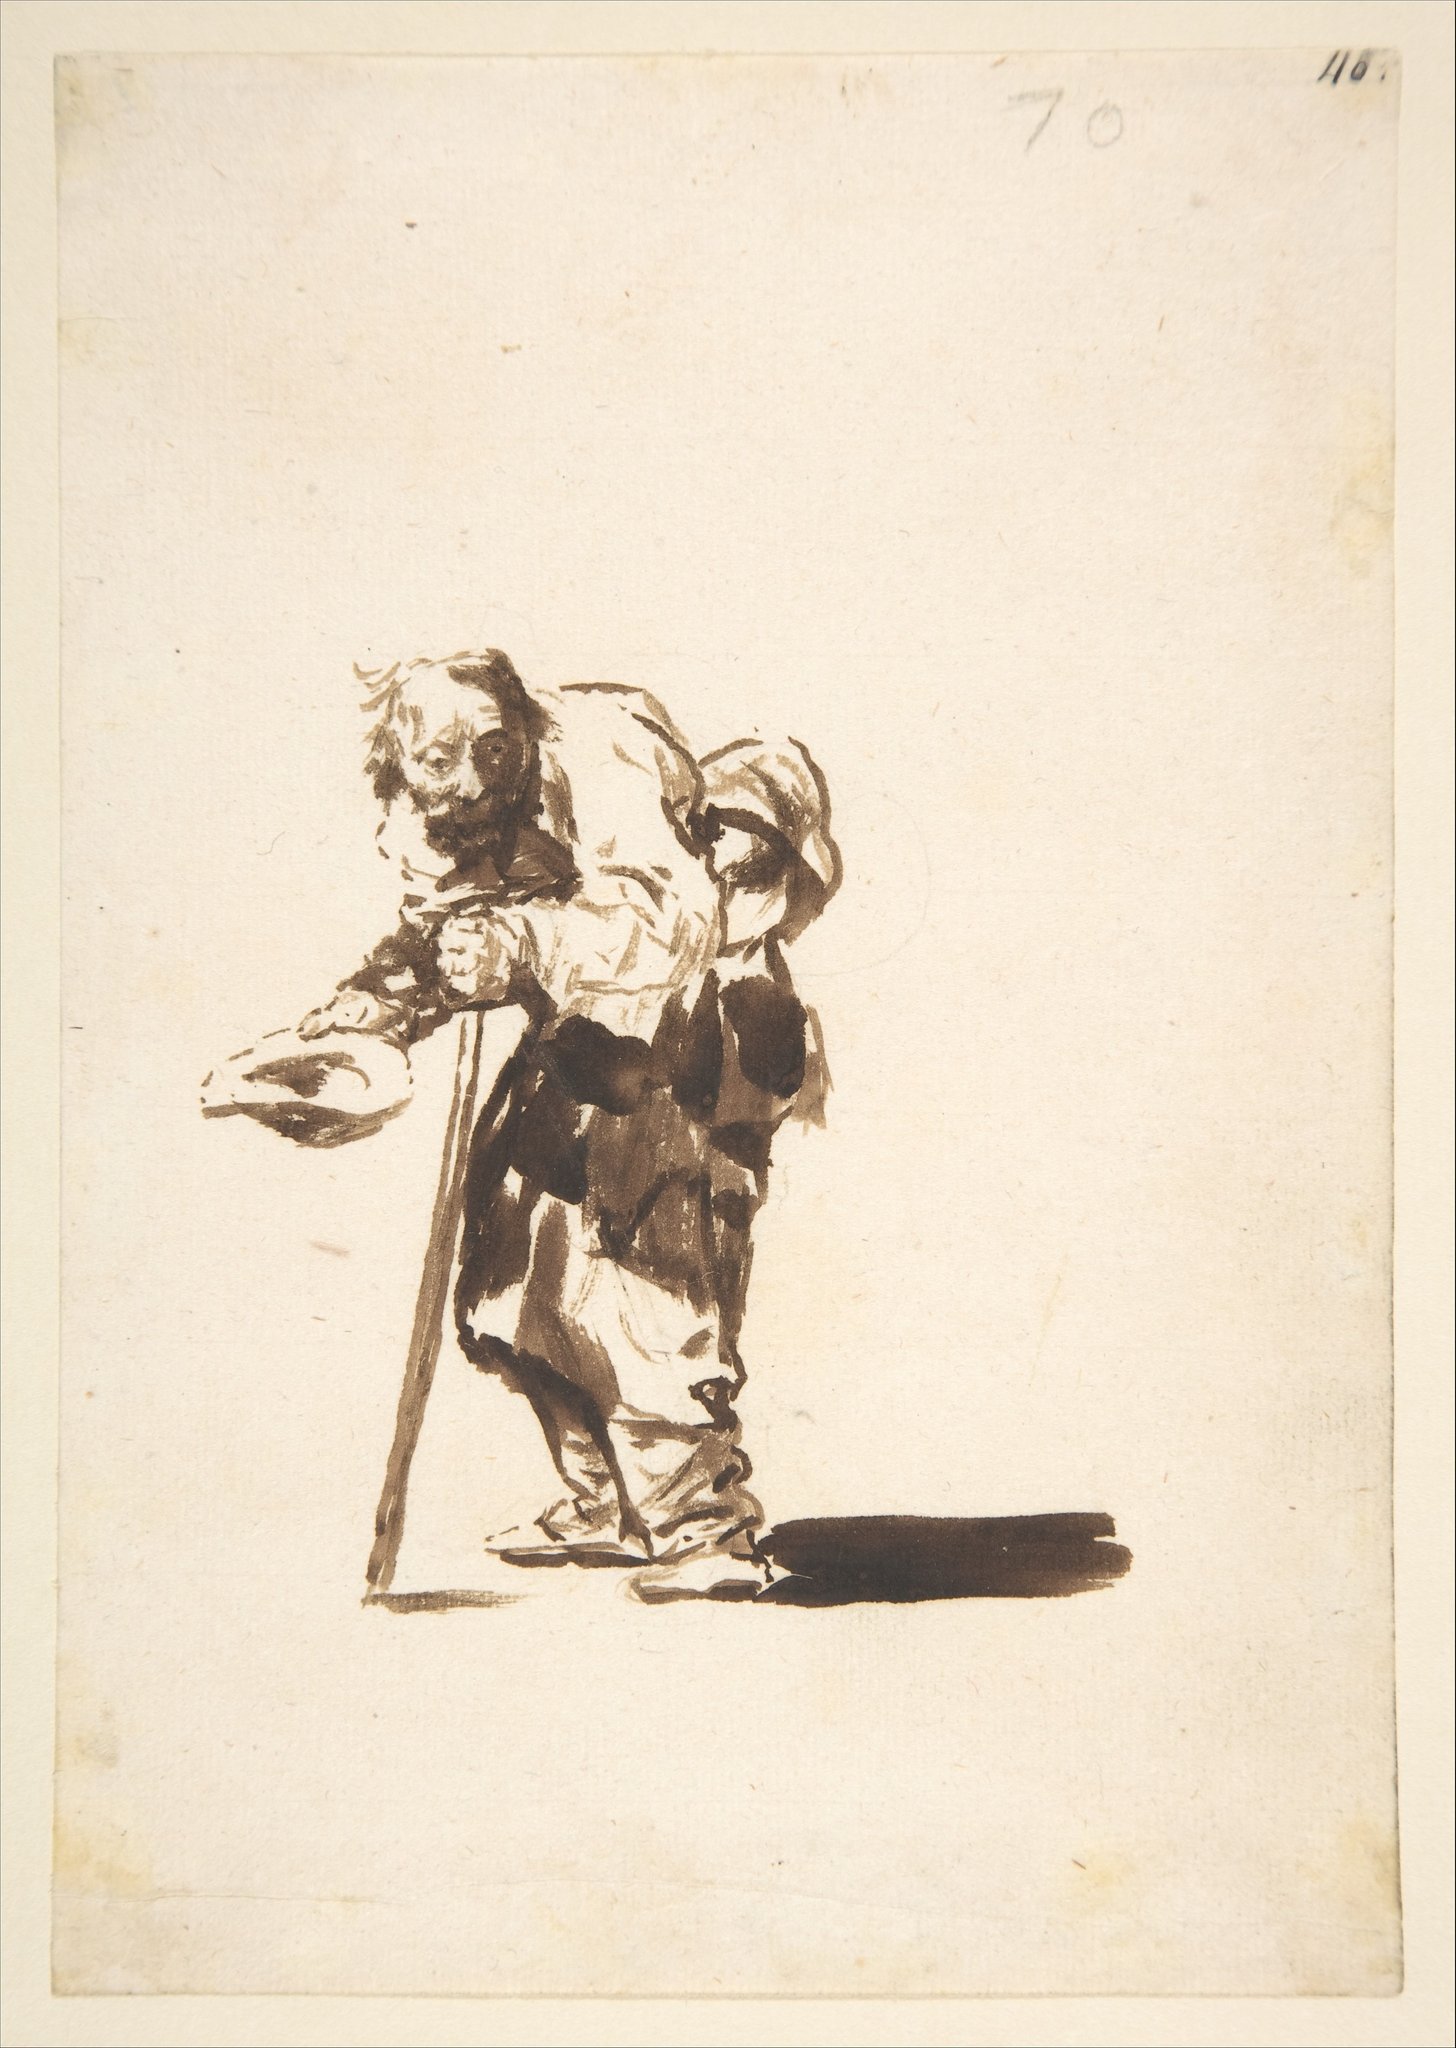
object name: drawing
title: Beggar with a staff in his left hand; folio 70 from the "Images of Spain" Album (F)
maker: goya (francisco de goya y lucientes)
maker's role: artist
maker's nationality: spanish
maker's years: 1746-1828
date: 1812-1820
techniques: brush, wash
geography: spain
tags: men